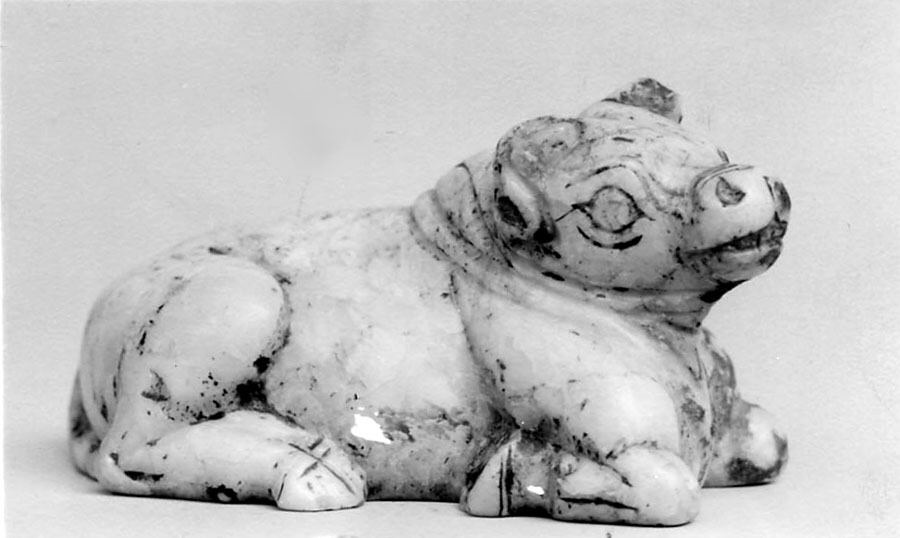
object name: statuette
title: Reclining Bull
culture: chinese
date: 618-907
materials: marble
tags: bulls